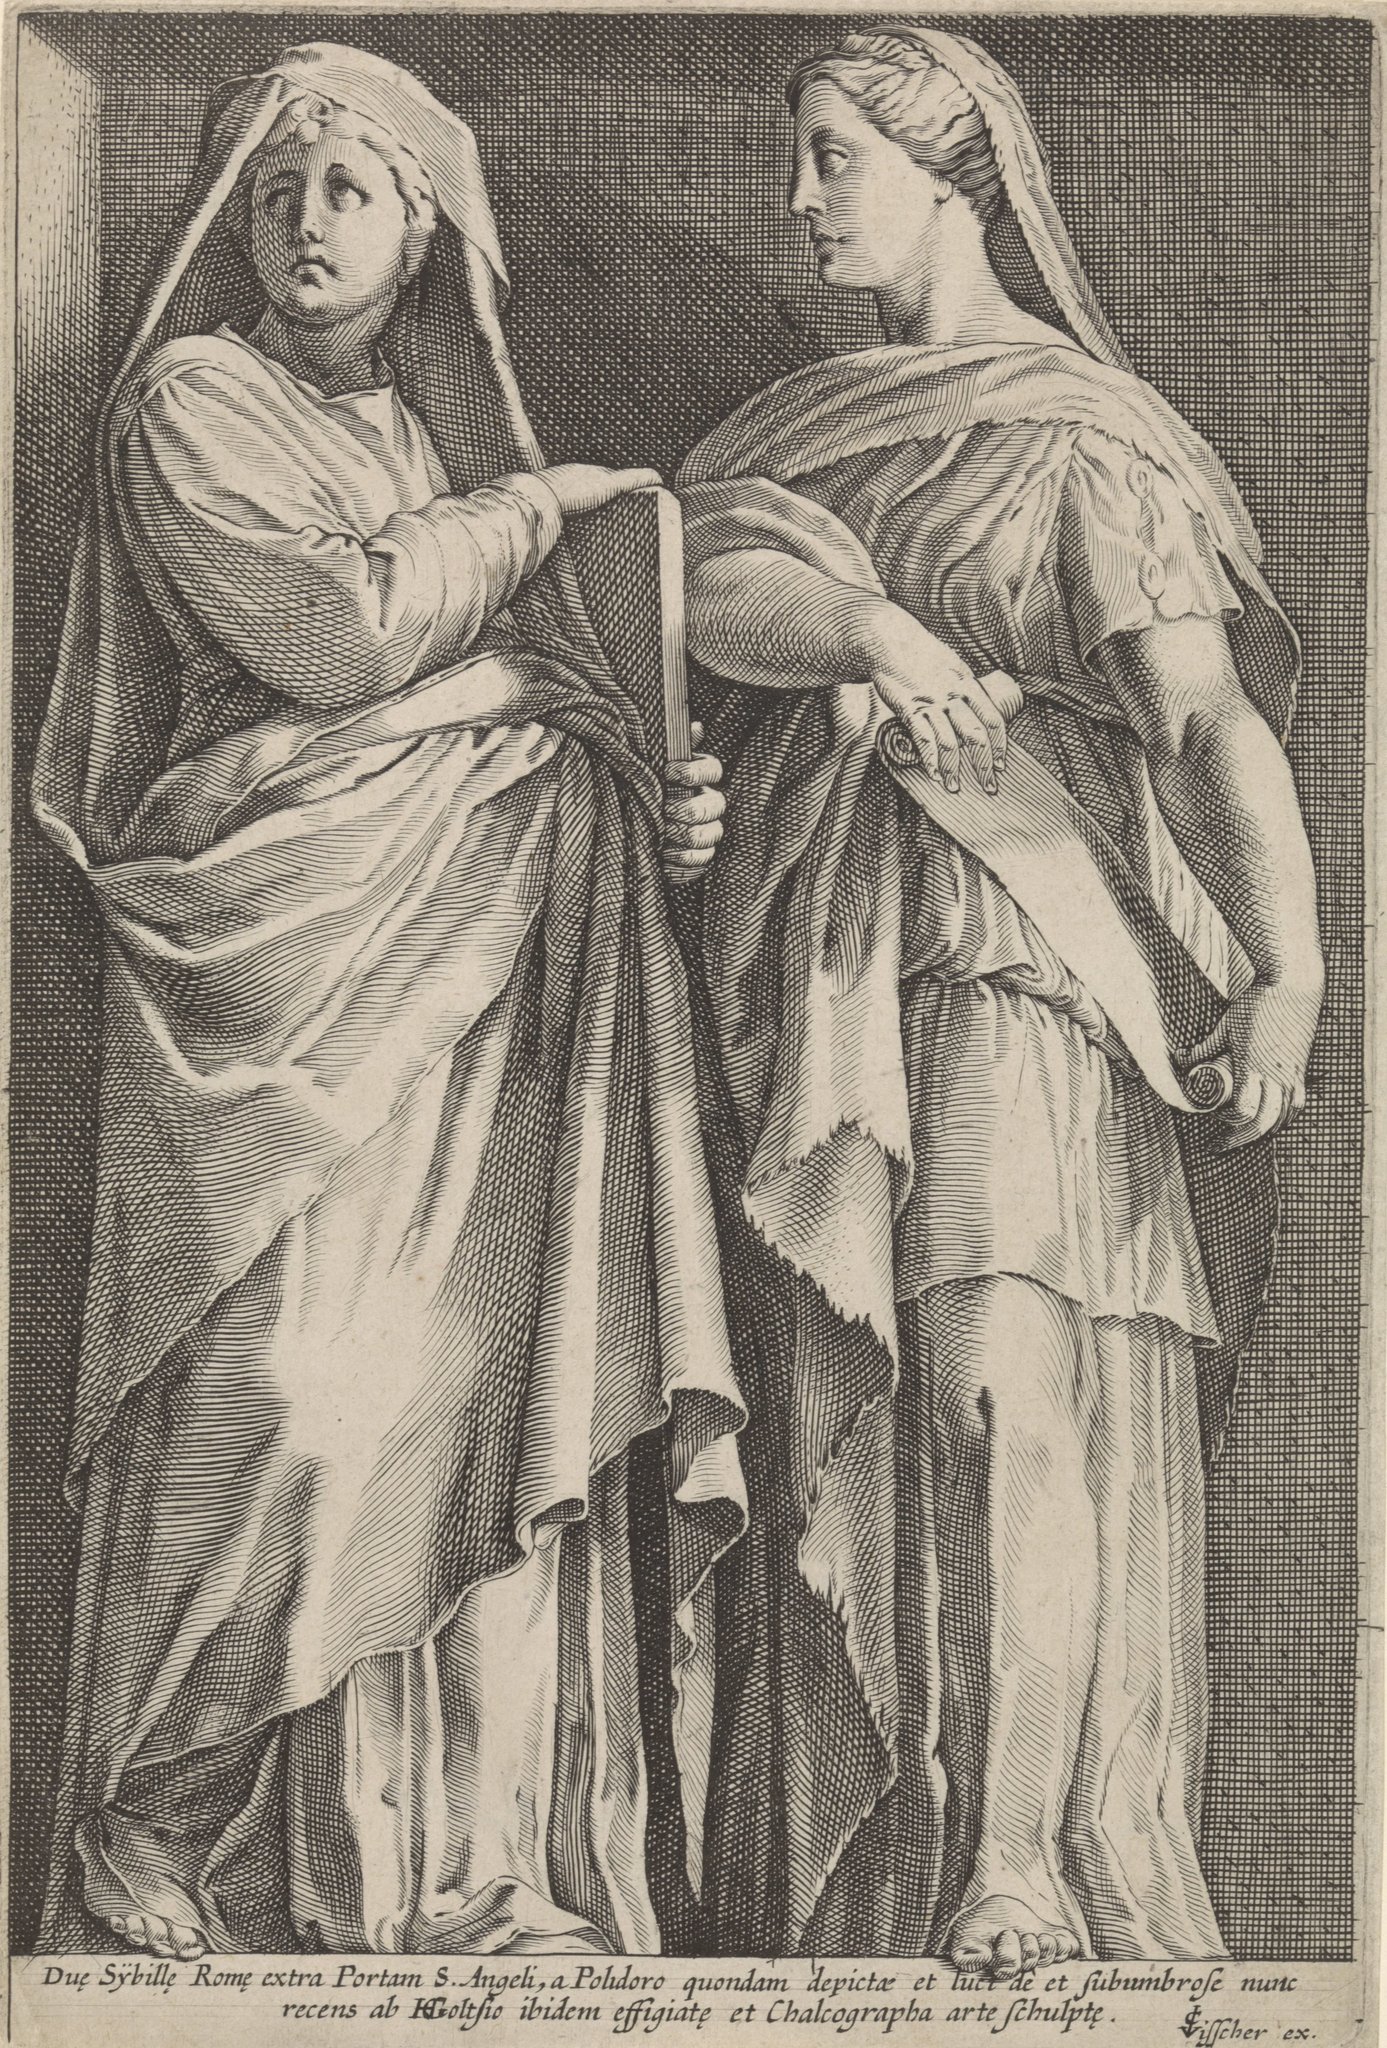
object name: print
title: Twee sibillen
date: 1601-1652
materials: paper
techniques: engraving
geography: amsterdam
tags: sibyls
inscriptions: collector's mark: Lugt 2228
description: Twee sibillen, de een met een boek of tablet in de handen, de ander met een boekrol in de handen. Onder de voorstelling een tweeregelige tekst in Latijn.